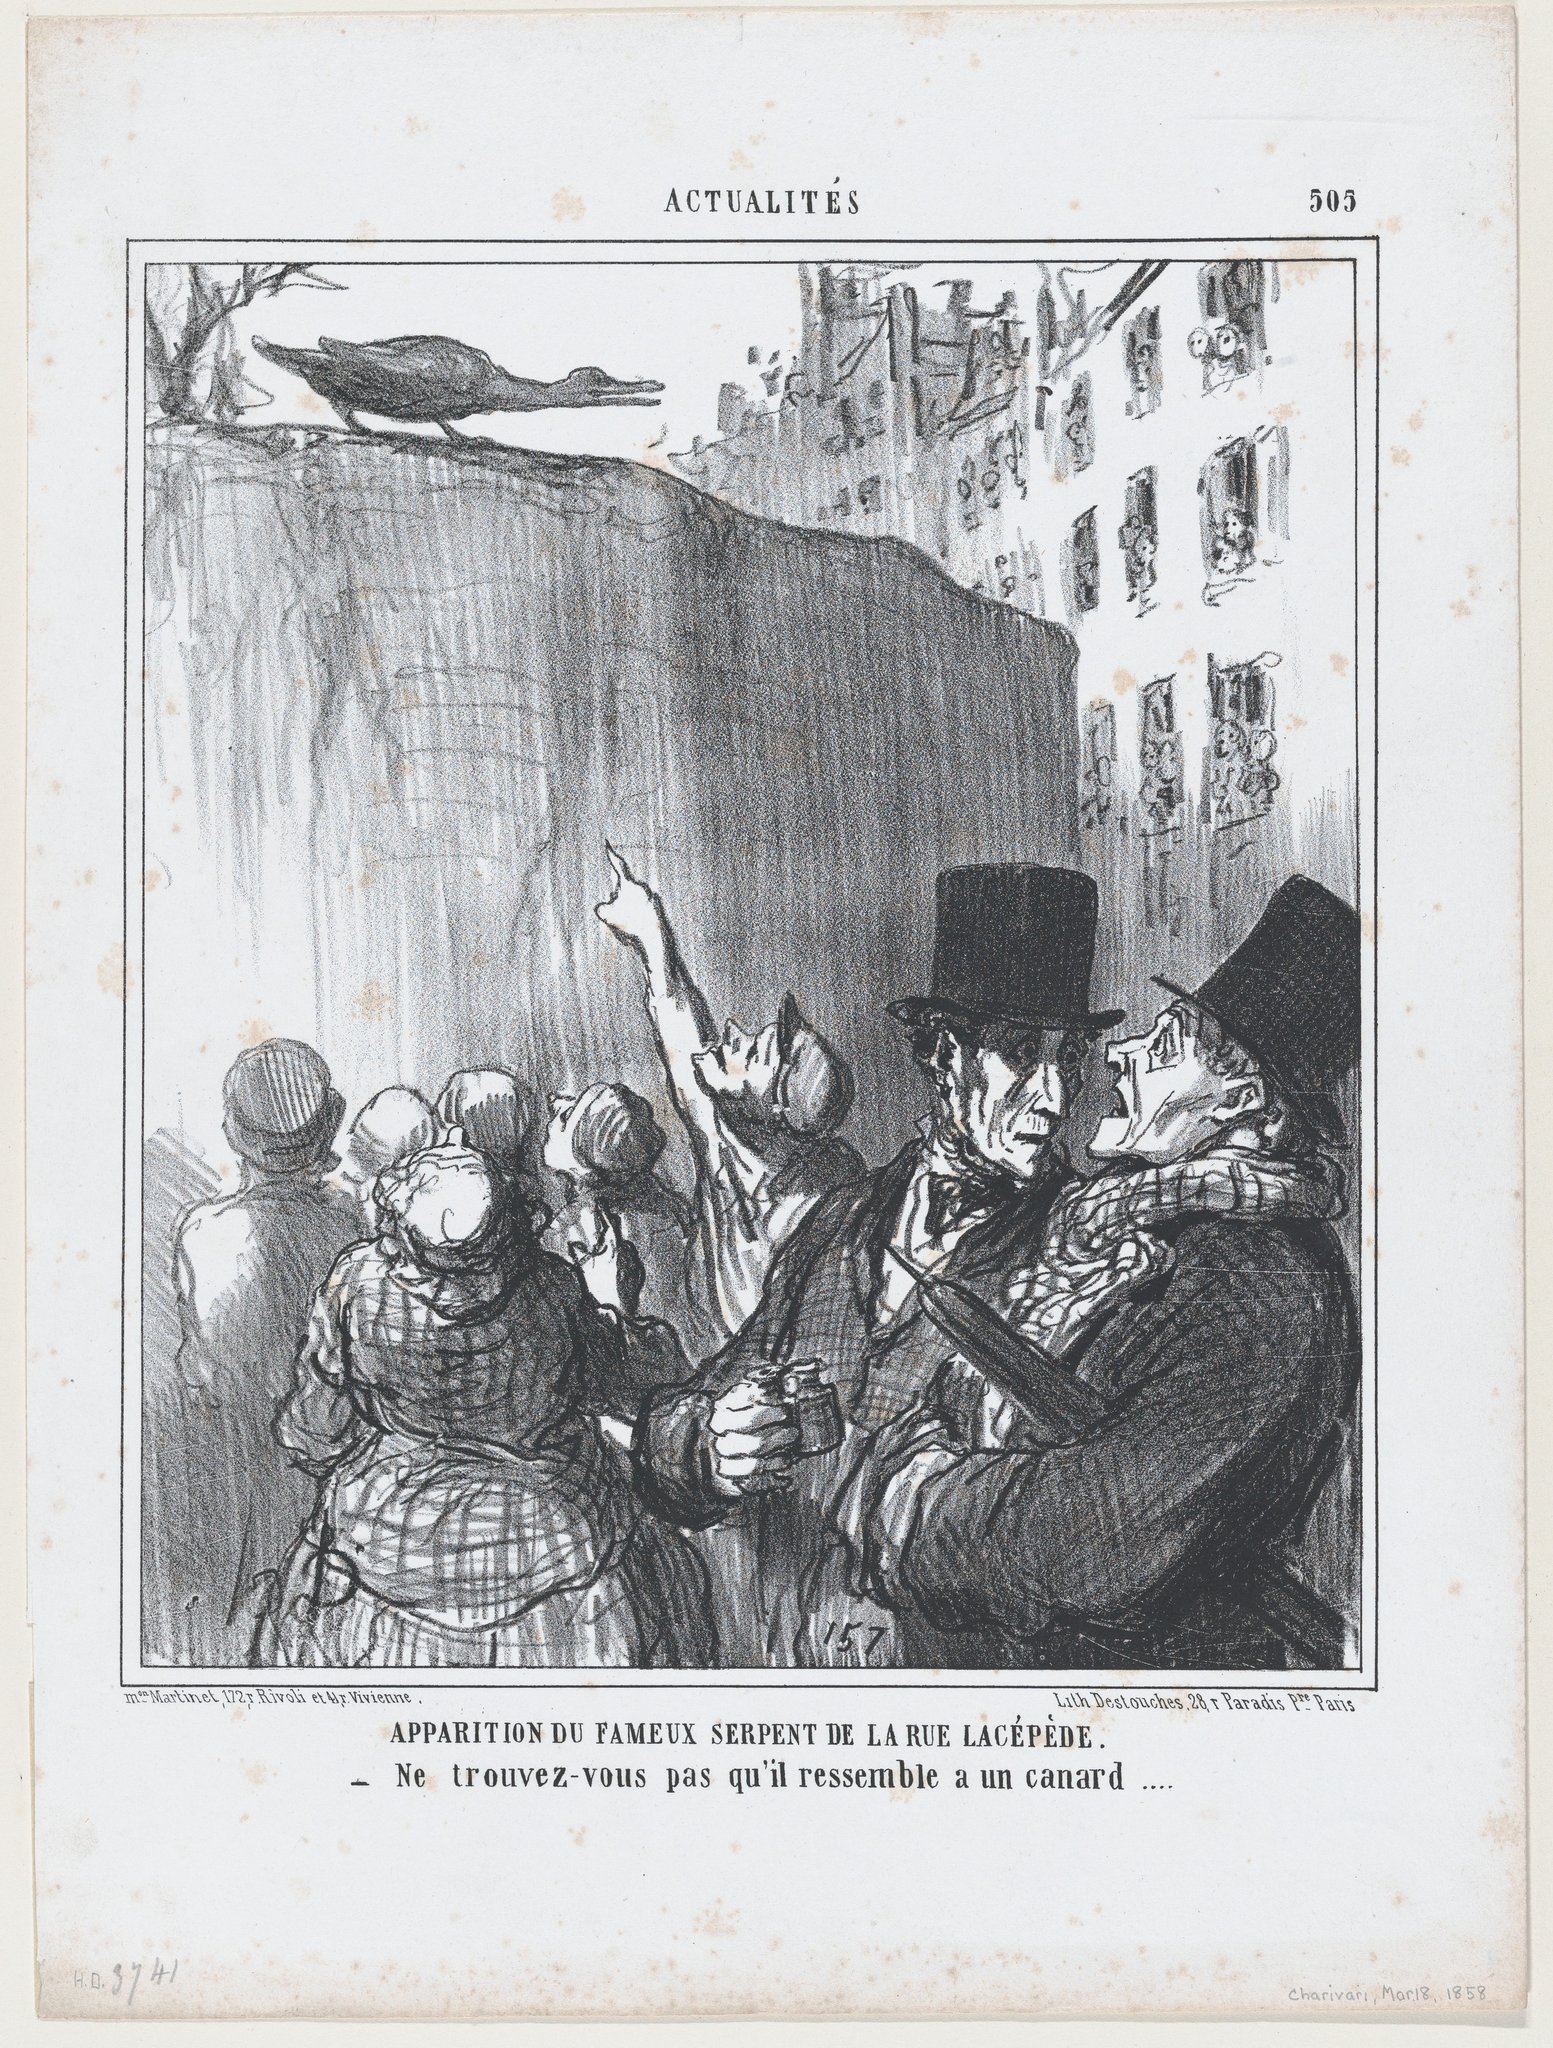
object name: print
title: Apparition du fameux serpent de la rue Lacépède..., from Actualités, published in "Le Charivari"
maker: honoré daumier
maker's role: artist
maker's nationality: french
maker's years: 1808-1879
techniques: lithograph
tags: birds,men